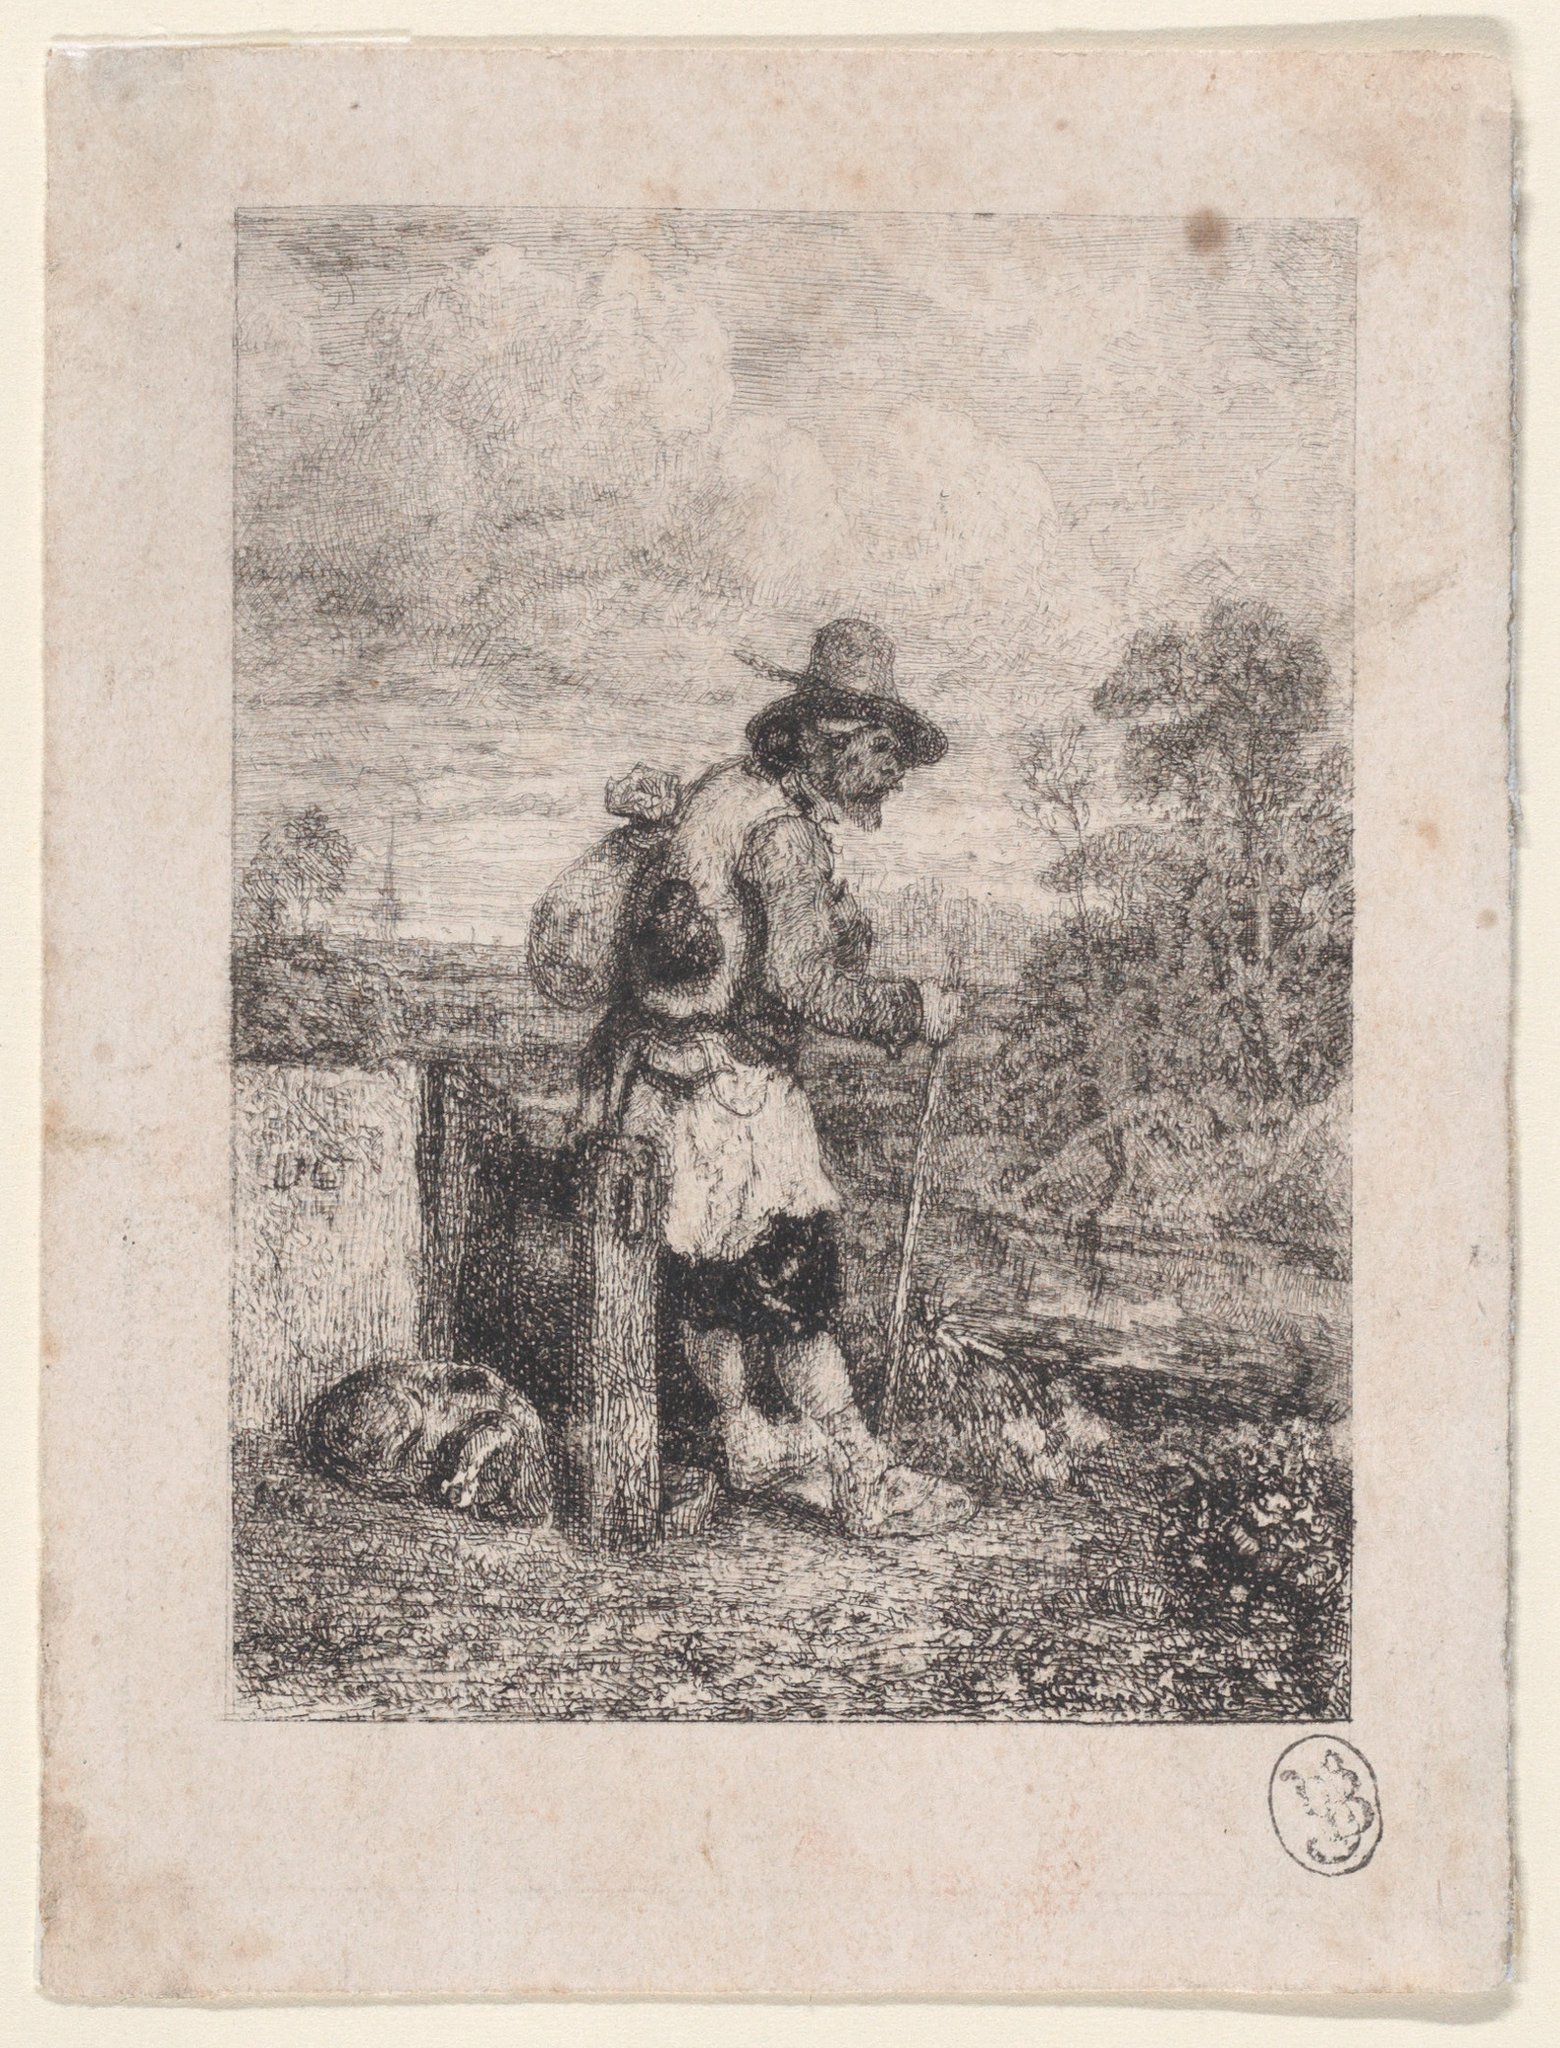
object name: print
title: A Beggar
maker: alexandre-gabriel decamps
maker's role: artist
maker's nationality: french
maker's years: 1803-1860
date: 1833-1838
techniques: etching